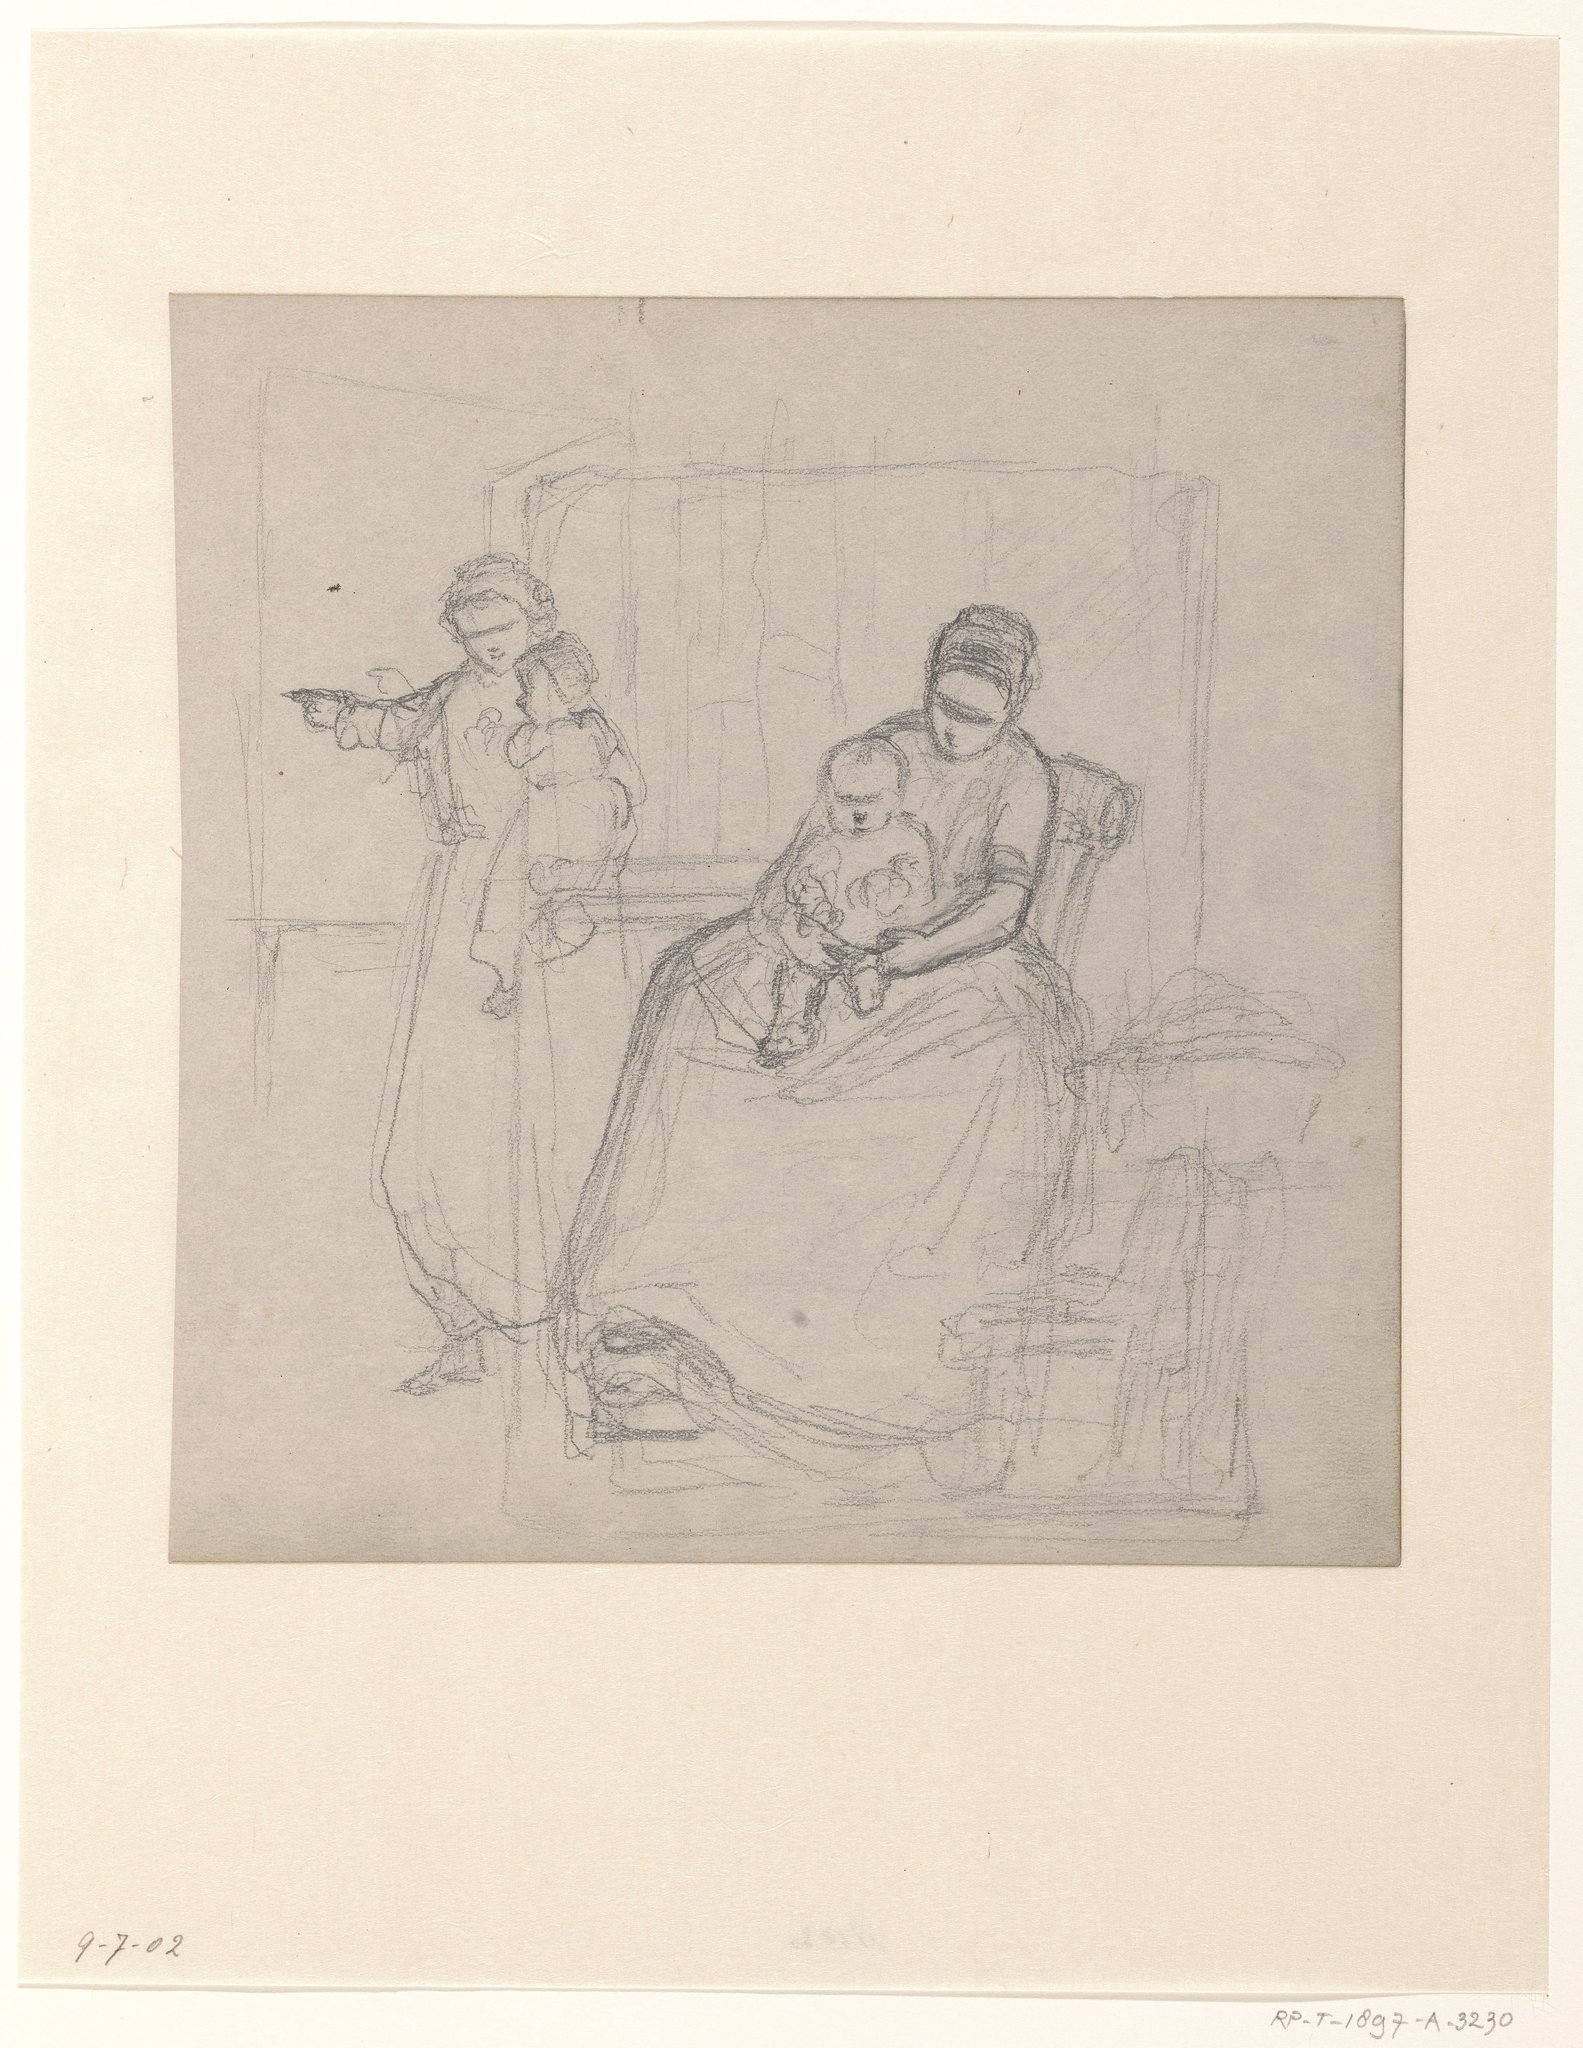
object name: drawing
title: Moeder met kind op schoot en moeder met kind op de arm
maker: hendrik valkenburg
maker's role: draughtsman, painter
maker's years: 1826-1896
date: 1836-1896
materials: chalk, paper, pencil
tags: adult woman, interior of the house, mother and child(ren), woman and child(ren) (family group)